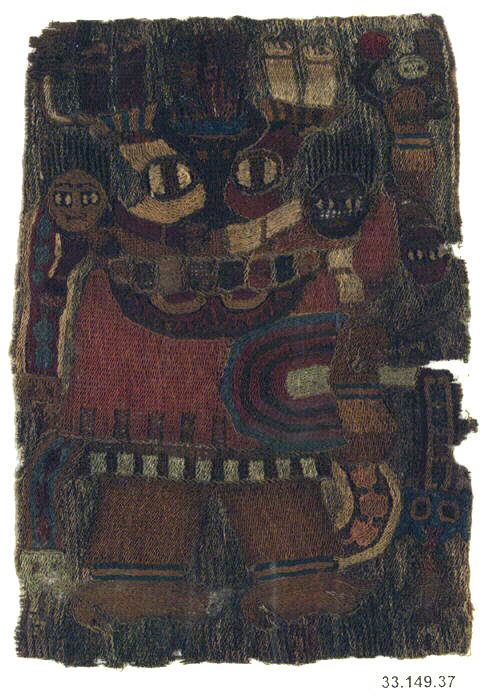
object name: mantle fragment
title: Embroidered Mantle Fragment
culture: paracas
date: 300-101 BCE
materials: animal fiber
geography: peru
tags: faces